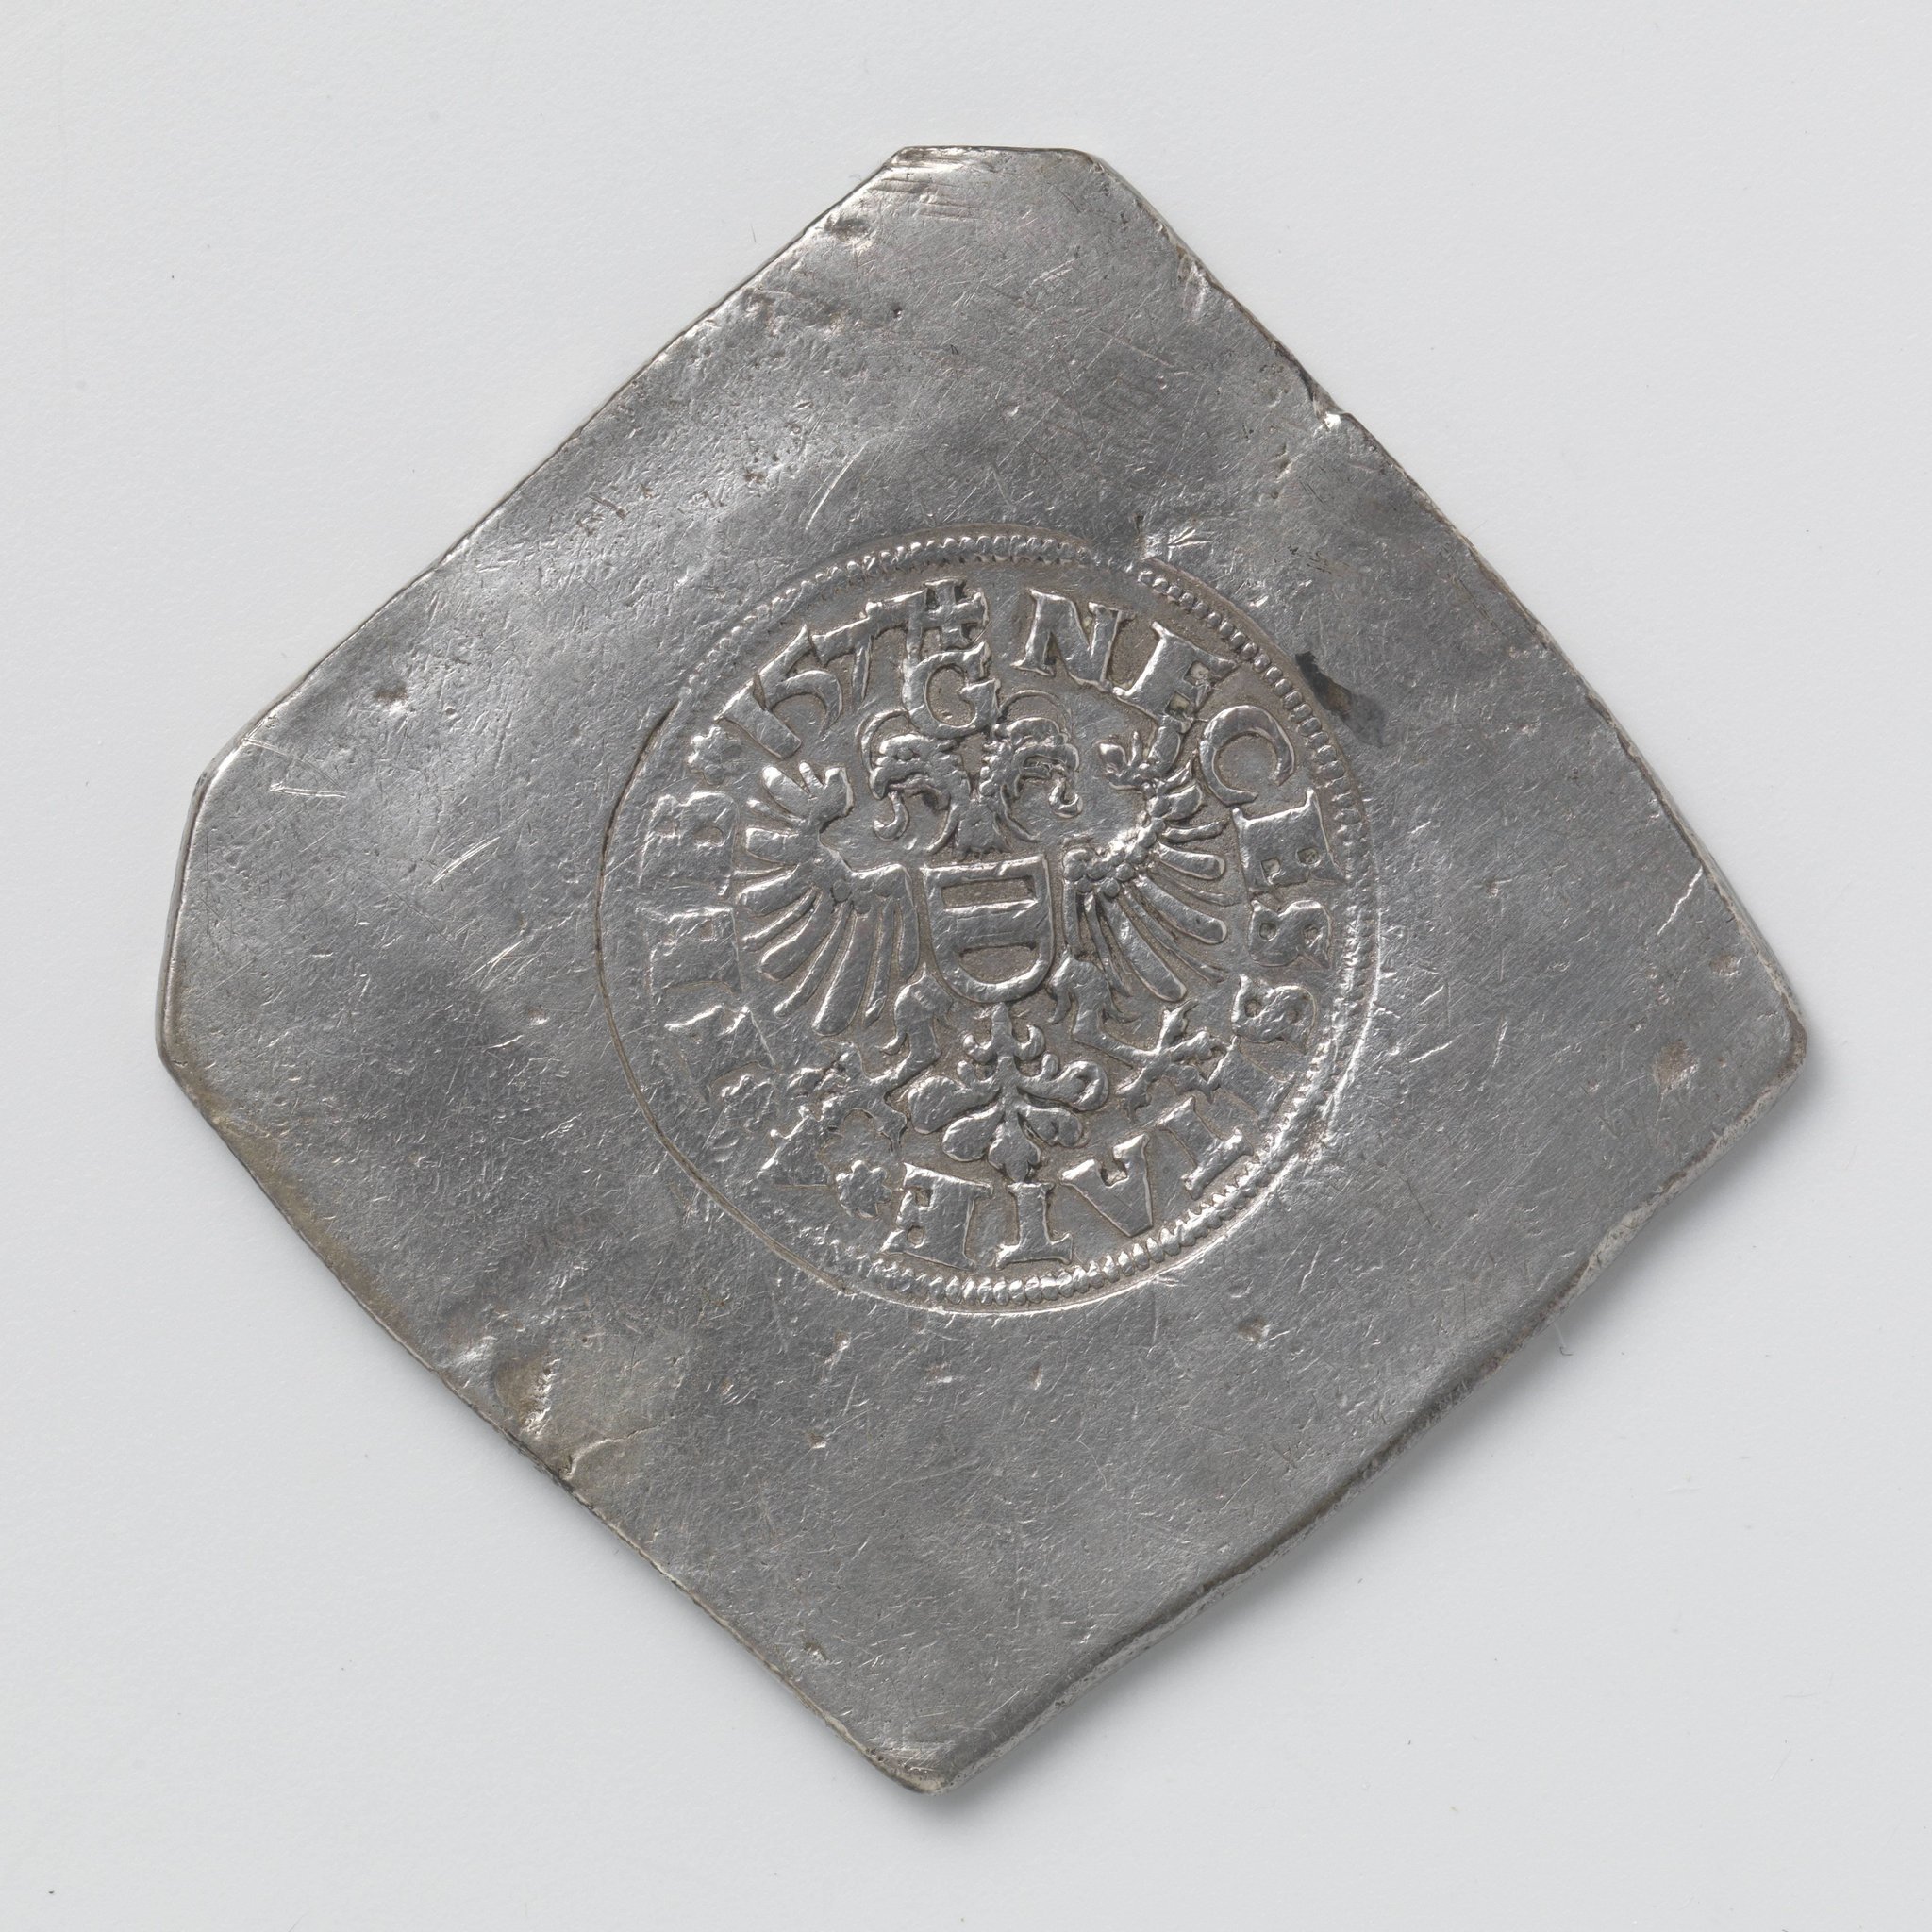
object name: koningsdaalder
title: Twelve emergency coins from Dutch cities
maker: balthasar wijntgens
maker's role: mintmaster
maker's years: 1577-1592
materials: silver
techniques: striking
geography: groningen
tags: groningen, tachtigjarige oorlog, inname van groningen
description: The cities besieged by the Spanish army for having revolted against Spanish rule in the 1570s experienced severe shortages of virtually everything, including money to pay the soldiers. Emergency money was therefore minted. Gold, silver, paper: anything in the cities under siege could be used as temporary currency.